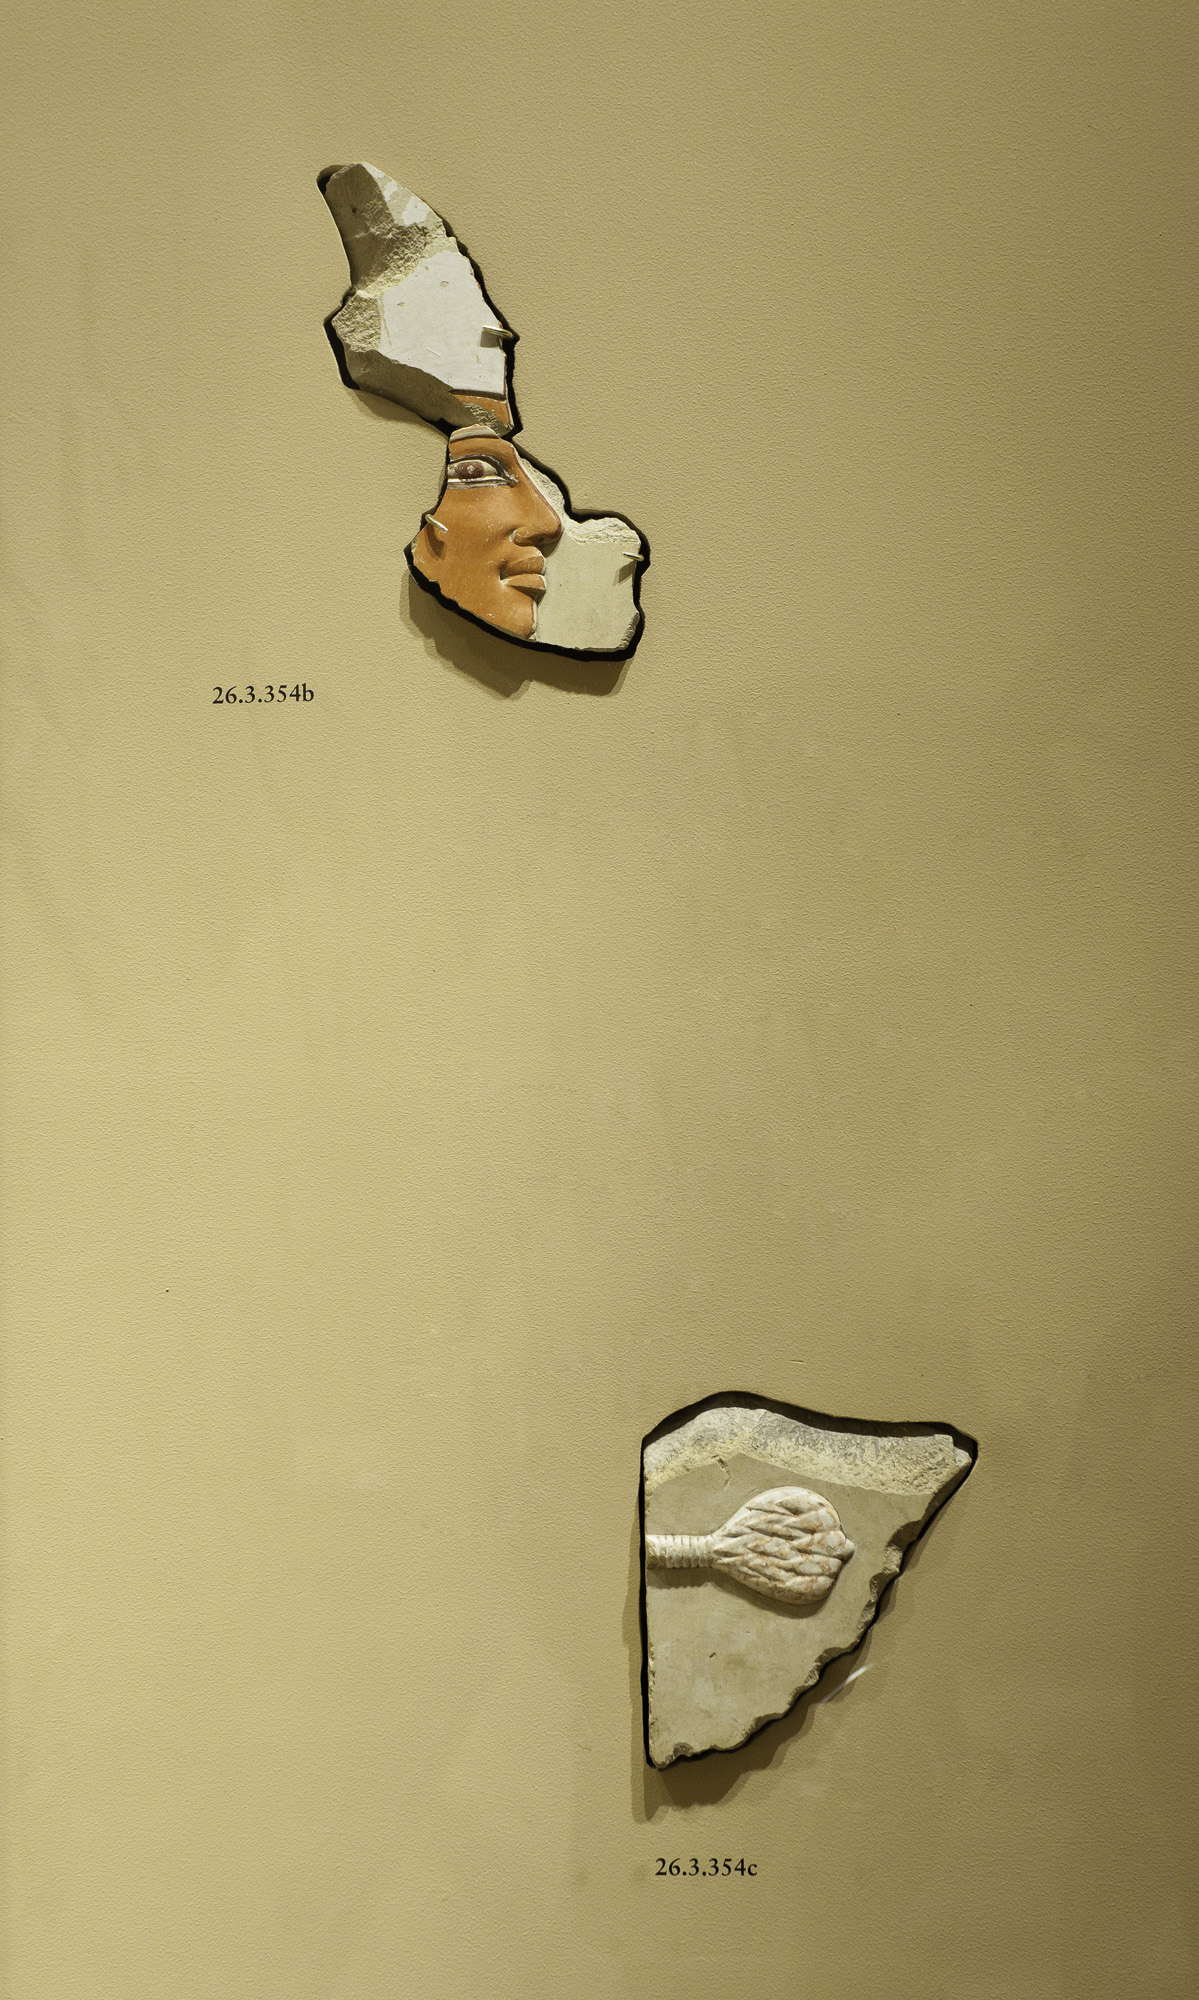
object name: relief, tomb of khety, mentuhotep ii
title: Relief Fragments from a Large Figure of Mentuhotep II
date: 2051-2000 BCE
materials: limestone, paint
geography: egypt